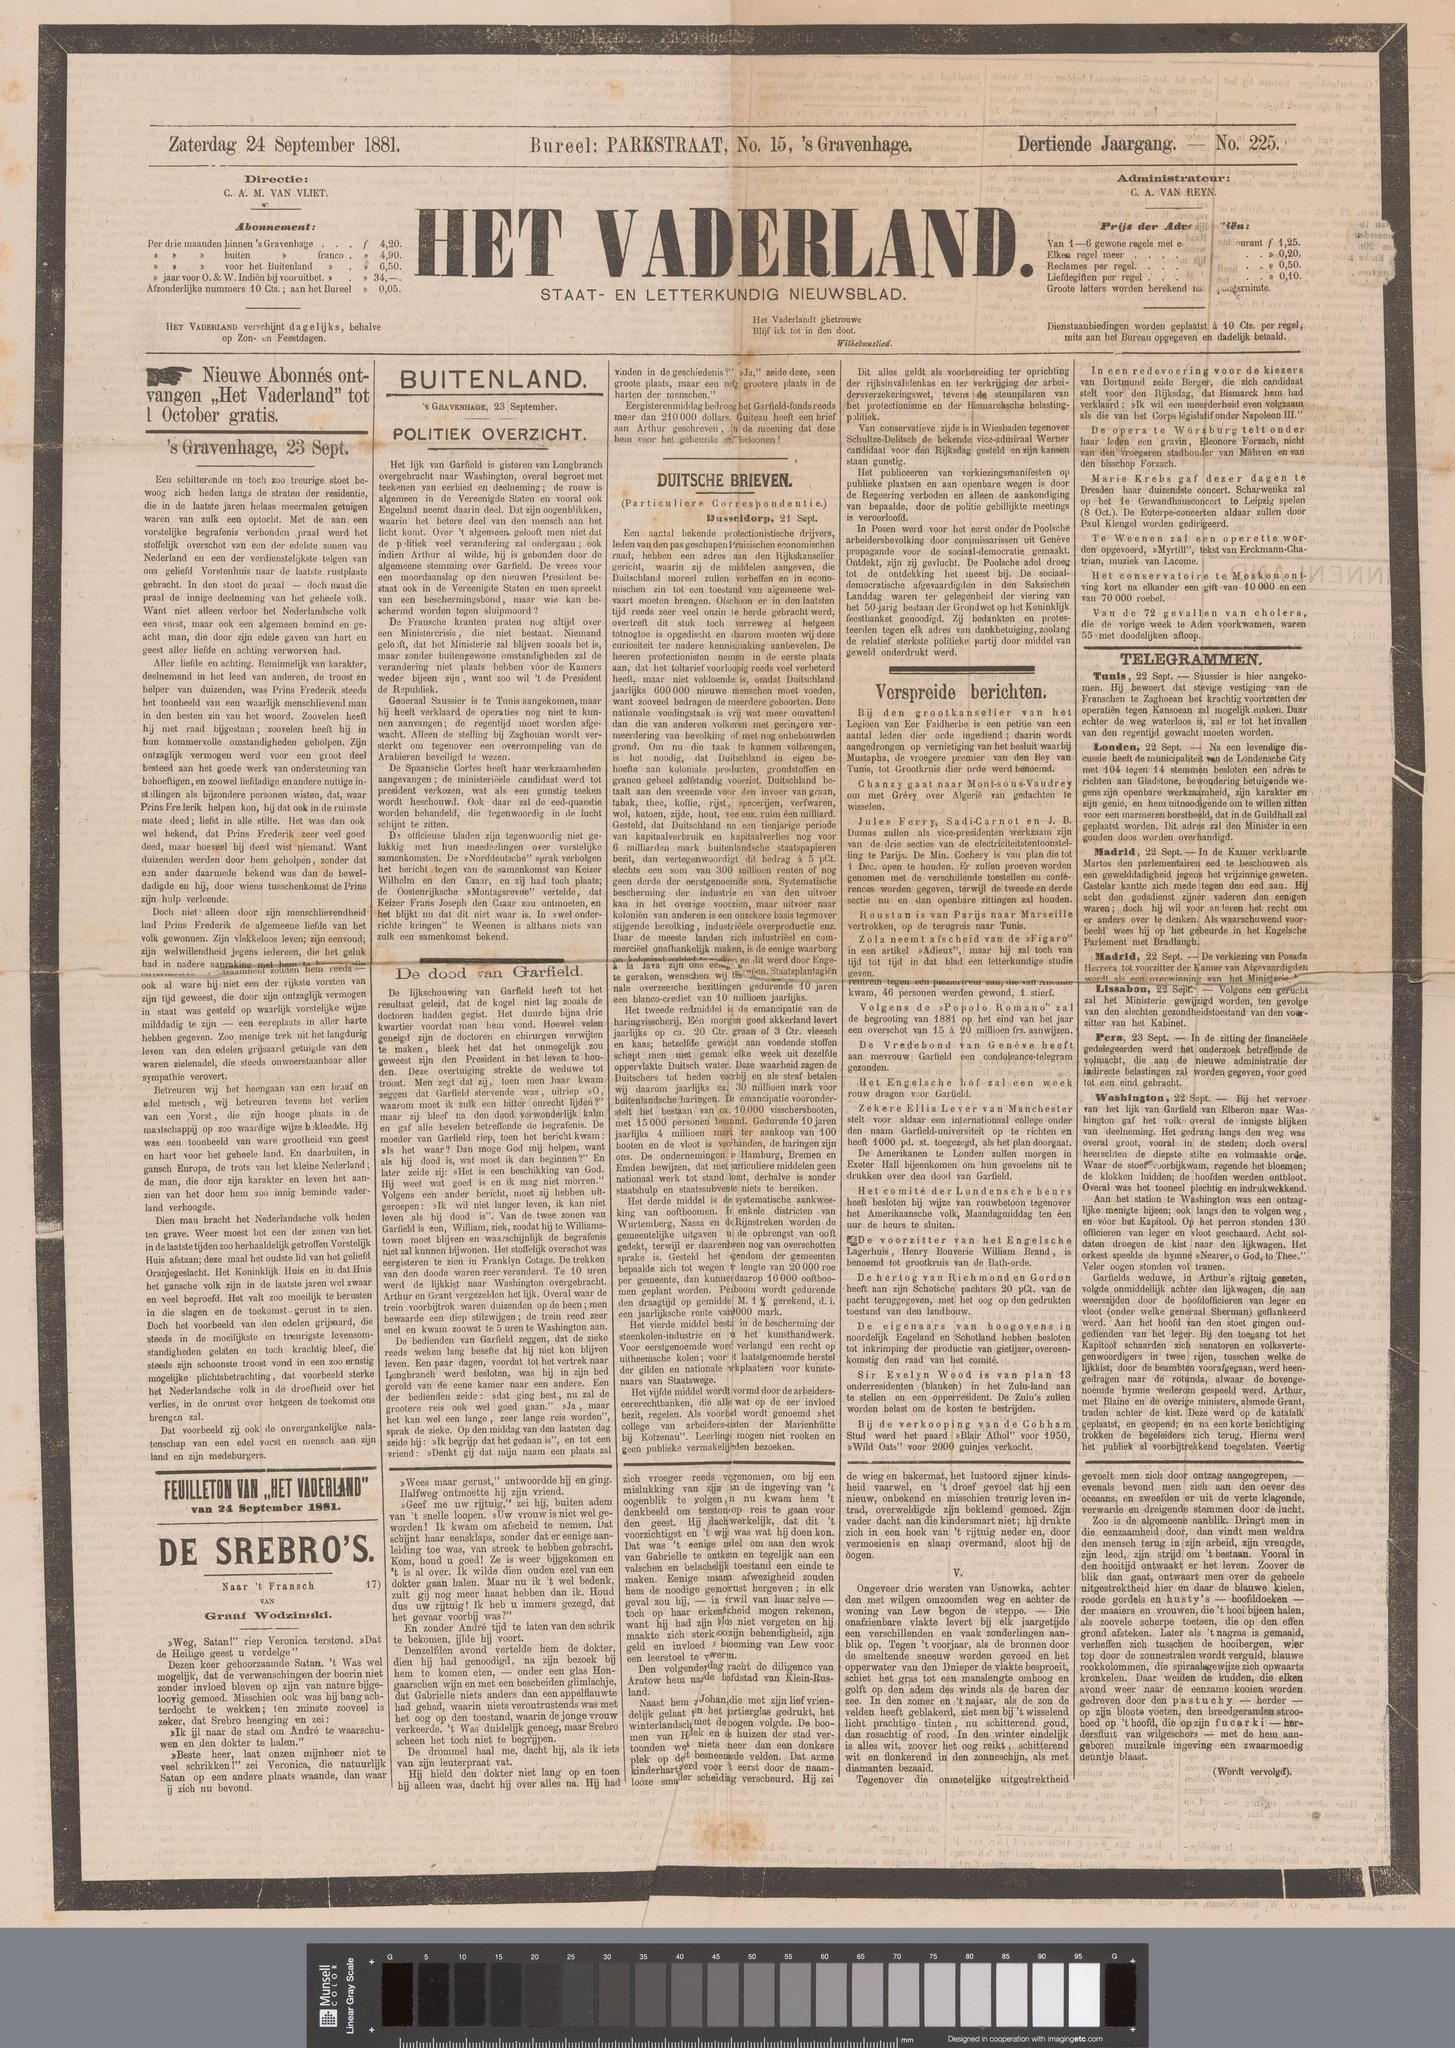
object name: newspaper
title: Het Vaderland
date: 1881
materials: paper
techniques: printing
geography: the hague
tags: berlin, frederik (prins der nederlanden), netherlands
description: Krant nr. 225 van de 13e jaargang van "Het Vaderland", 4 pp zwart omkaderd, met verslag van de begrafenis van prins Frederik.